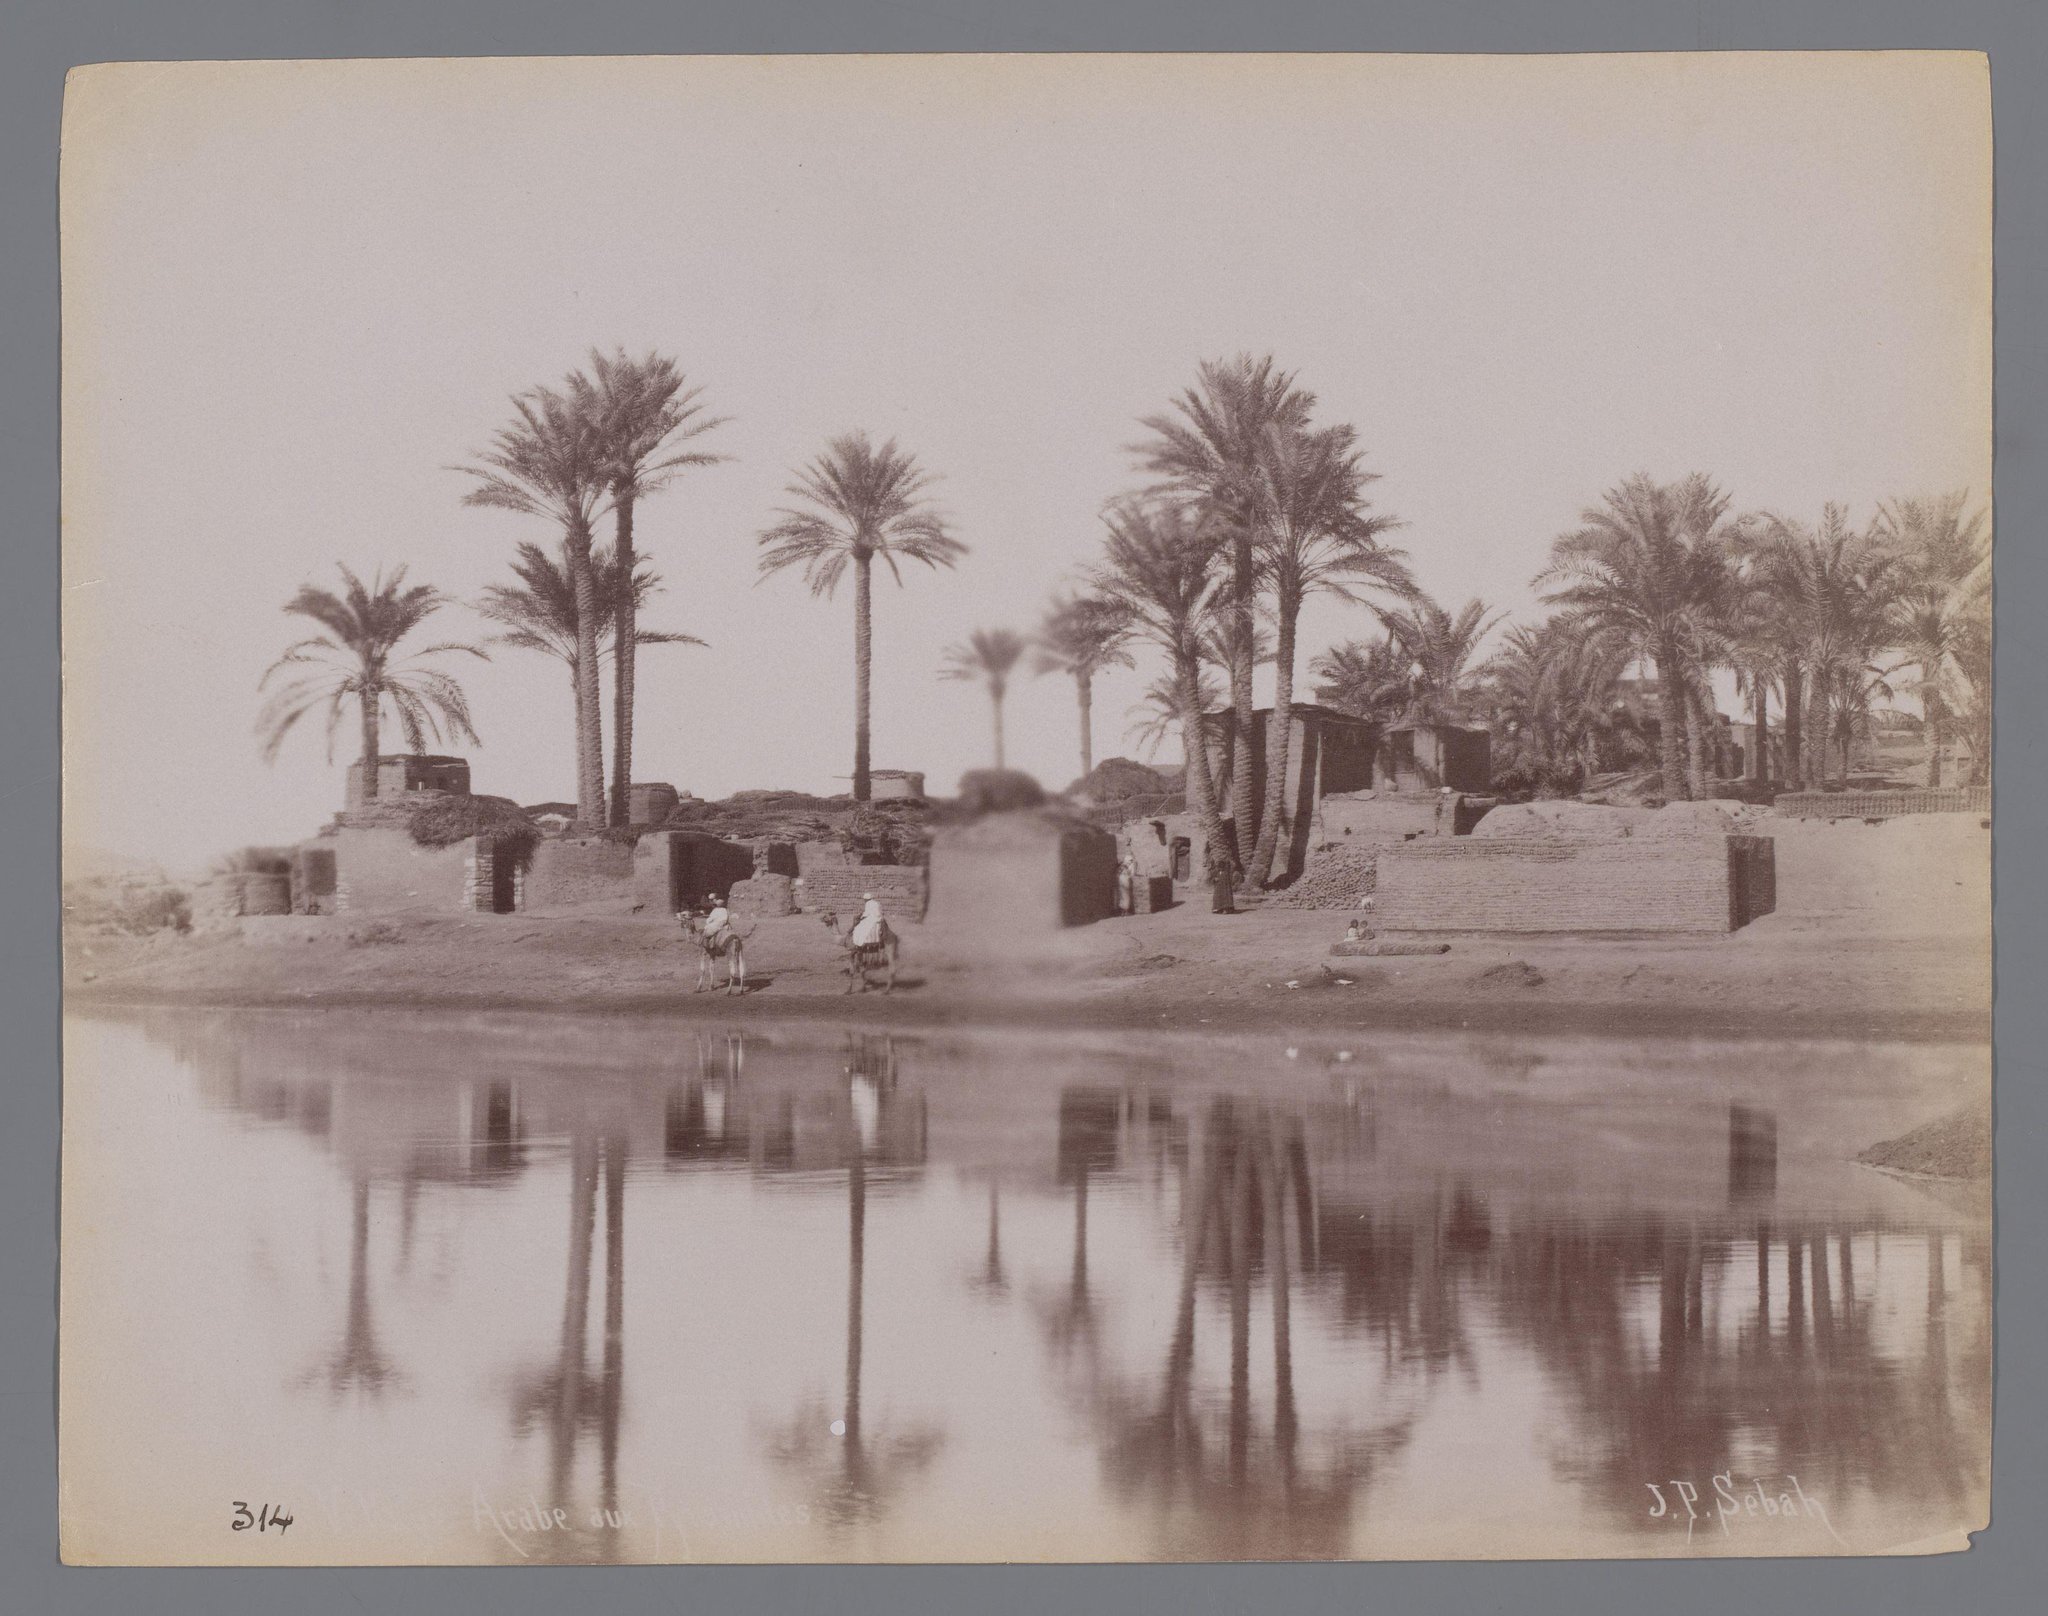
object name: photograph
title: Landschap met water, palmbomen en gebouwen, Midden-Oosten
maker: pascal sébah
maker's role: fotograaf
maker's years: 1823-1886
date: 1880-1900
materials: paper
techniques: albumen print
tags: midden-oosten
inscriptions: signature: ‘J.P. Sebah’, number: ‘314’, inscription: ‘Village arabe aux Piramides [?]’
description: Landschap met water, palmbomen en gebouwen, Midden-Oosten.